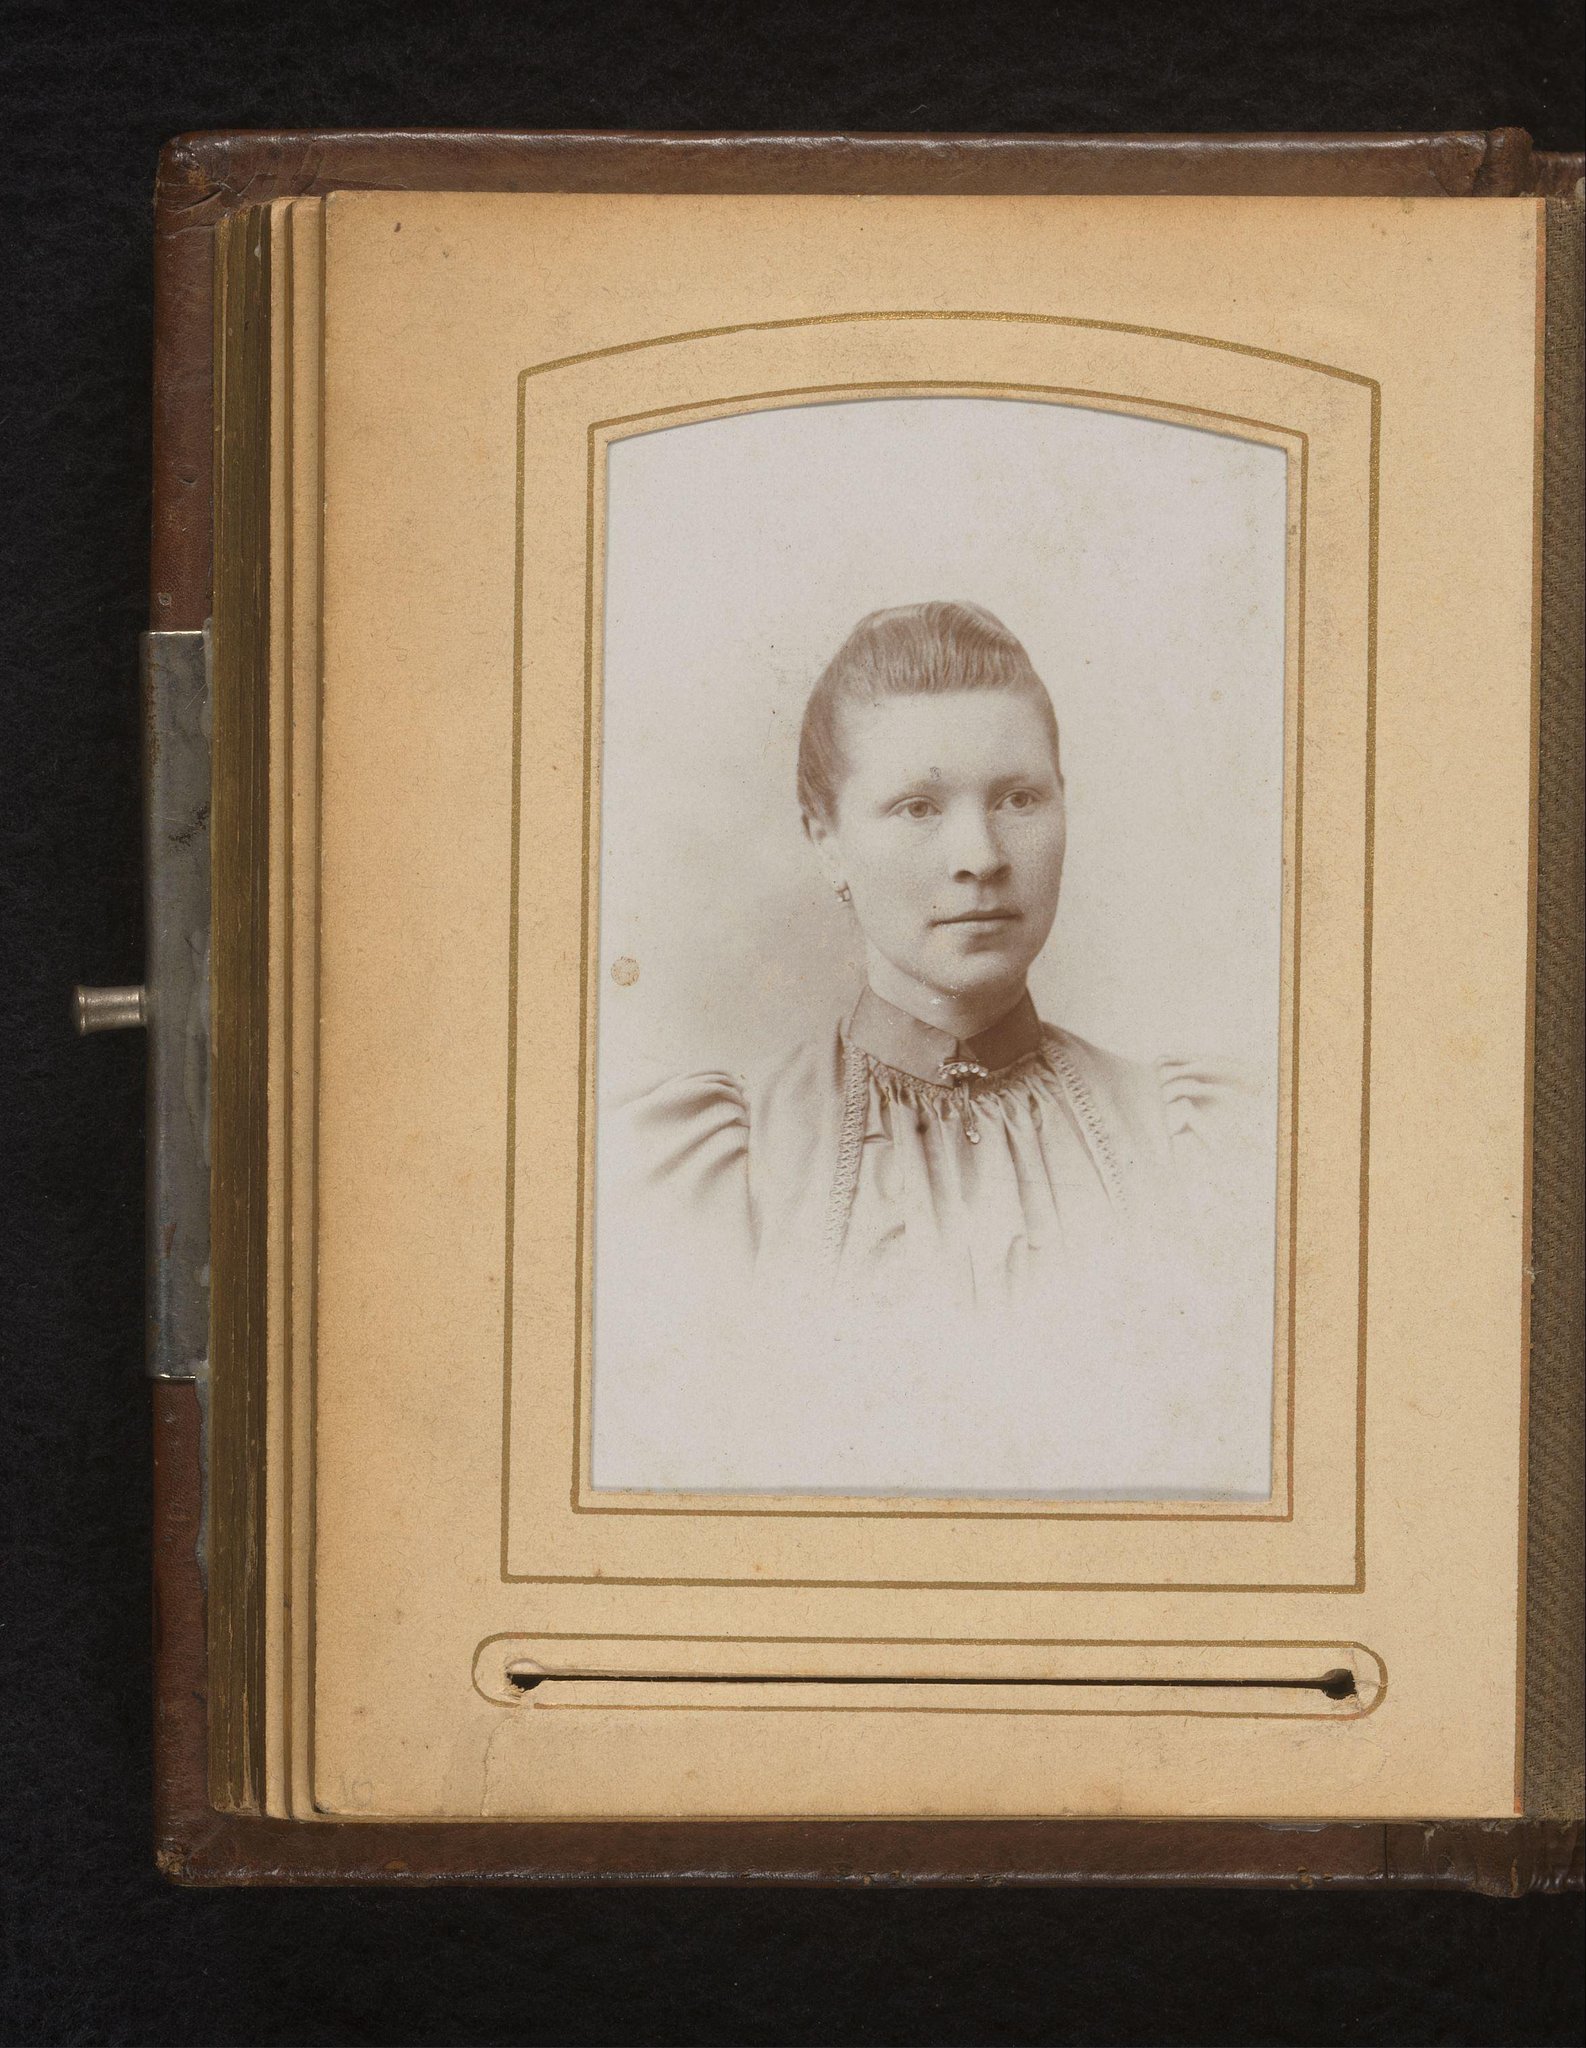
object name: album leaf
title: Portret van een vrouw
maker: cornelis johannes lodewicus vermeulen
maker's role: fotograaf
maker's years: 1861-1936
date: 1878-1896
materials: cardboard, photographic support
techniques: collodion silver print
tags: adult man, historical persons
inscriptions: inscription: ‘Photographische Ateliers/ C.J.L. Vermeulen/ Heerenstraat 6/ Heiligenweg/ hoek Singel/ Amsterdam’